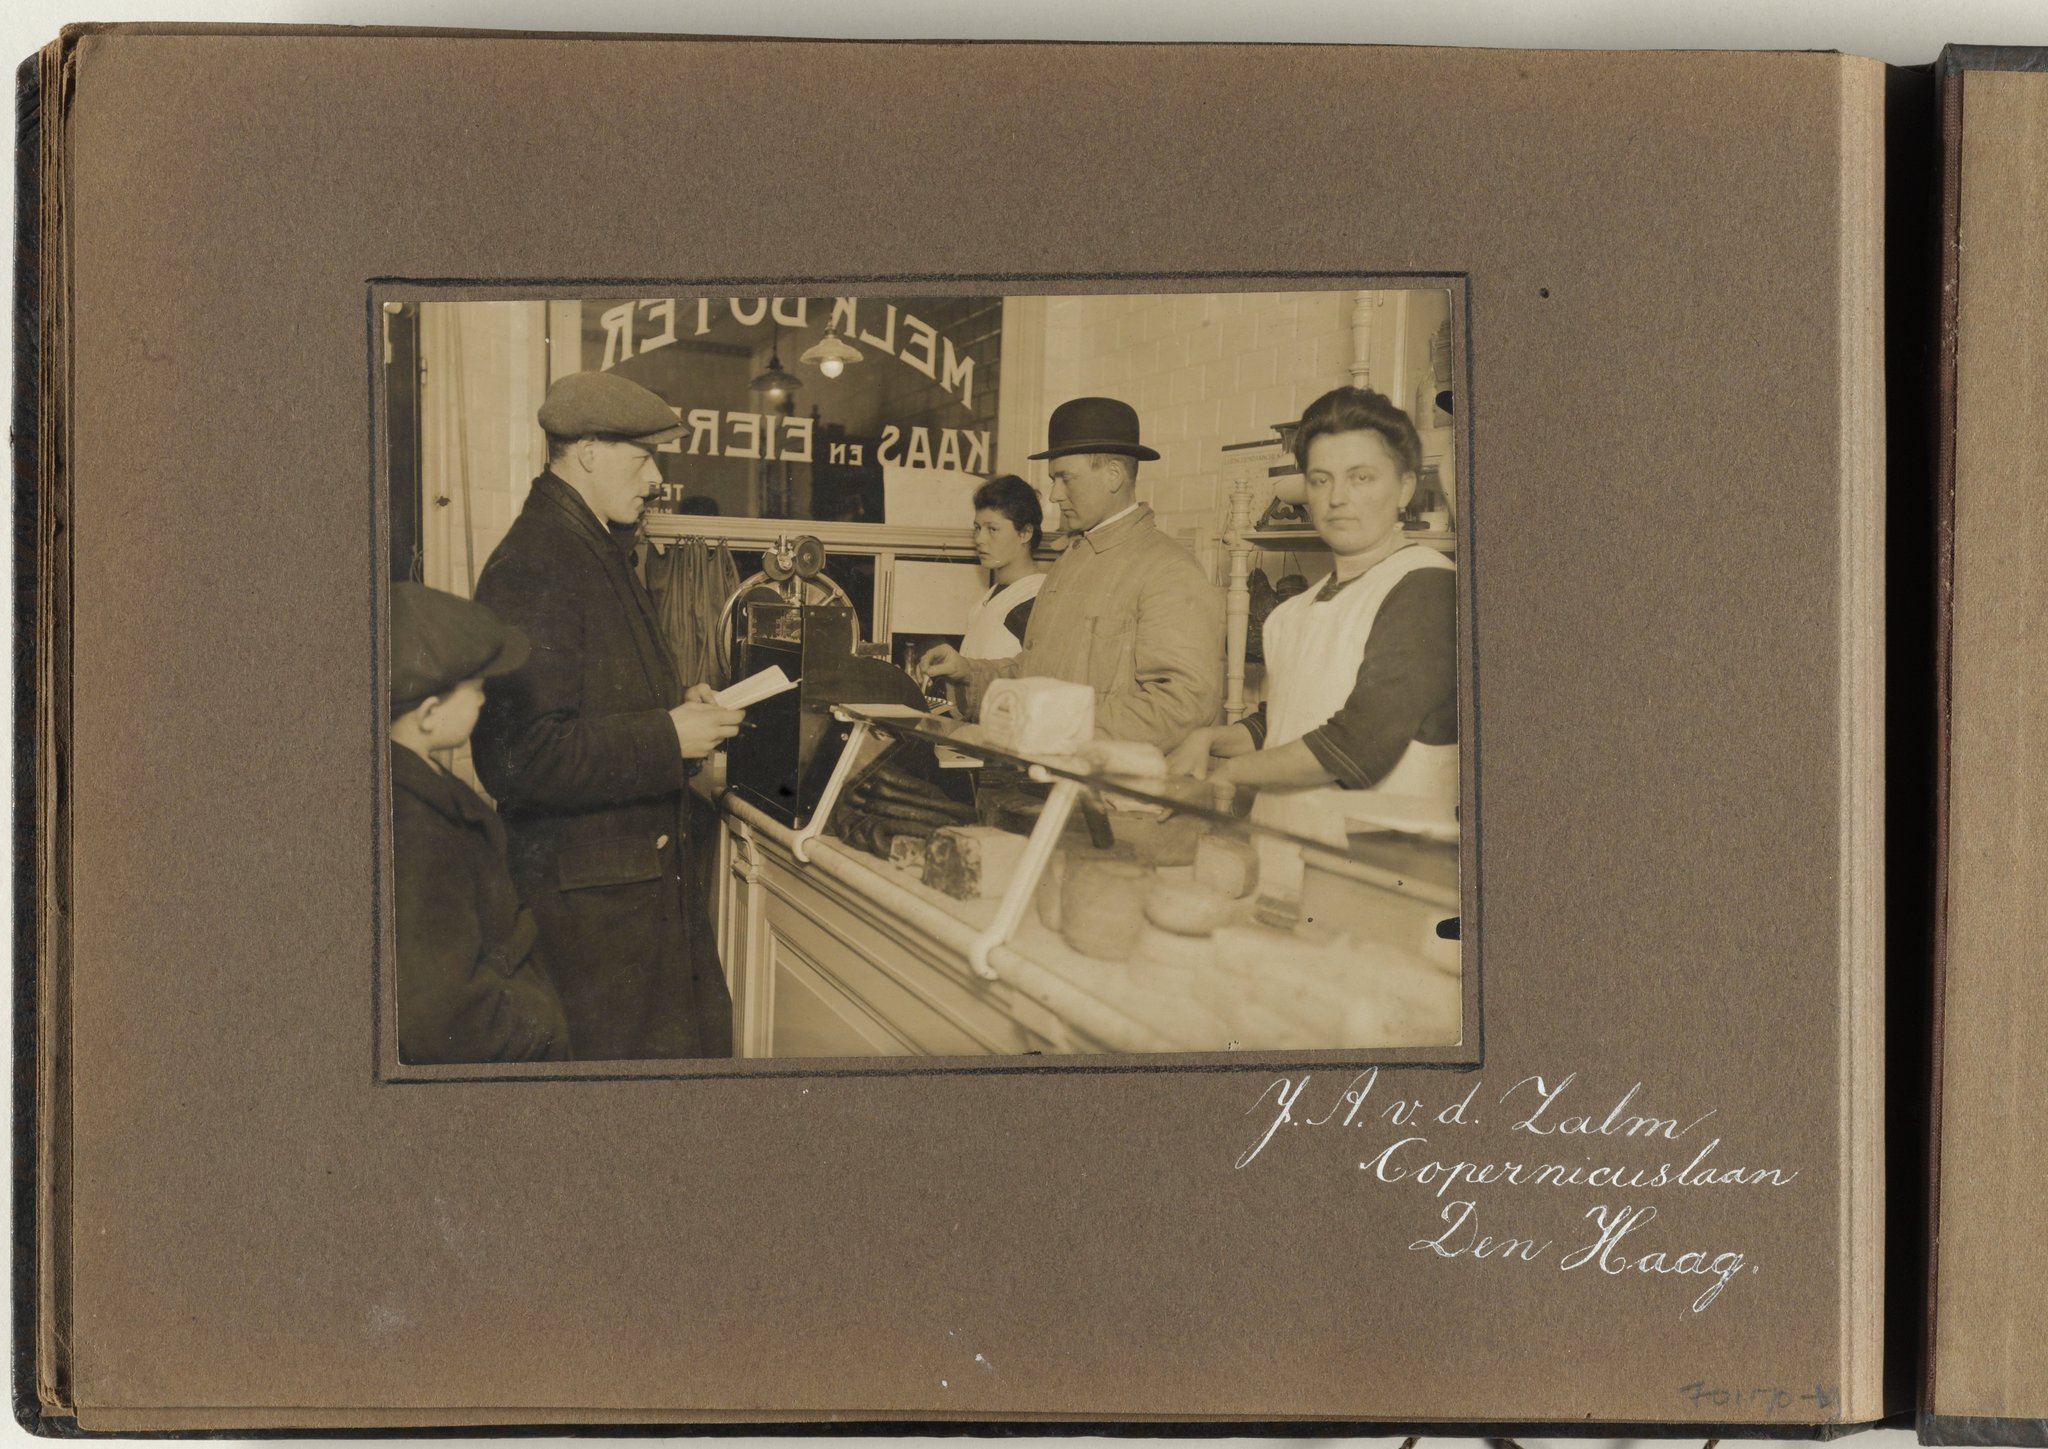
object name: album leaf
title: J.A. v.d. Zalm, Copernicuslaan, Den Haag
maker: Anonymous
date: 1925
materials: paper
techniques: gelatin silver print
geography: the hague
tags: counter ~ shop, dairy products and eggs, the hague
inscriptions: annotation: ‘J.A. v.d. Zalm/ Copernicuslaan/ Den Haag’